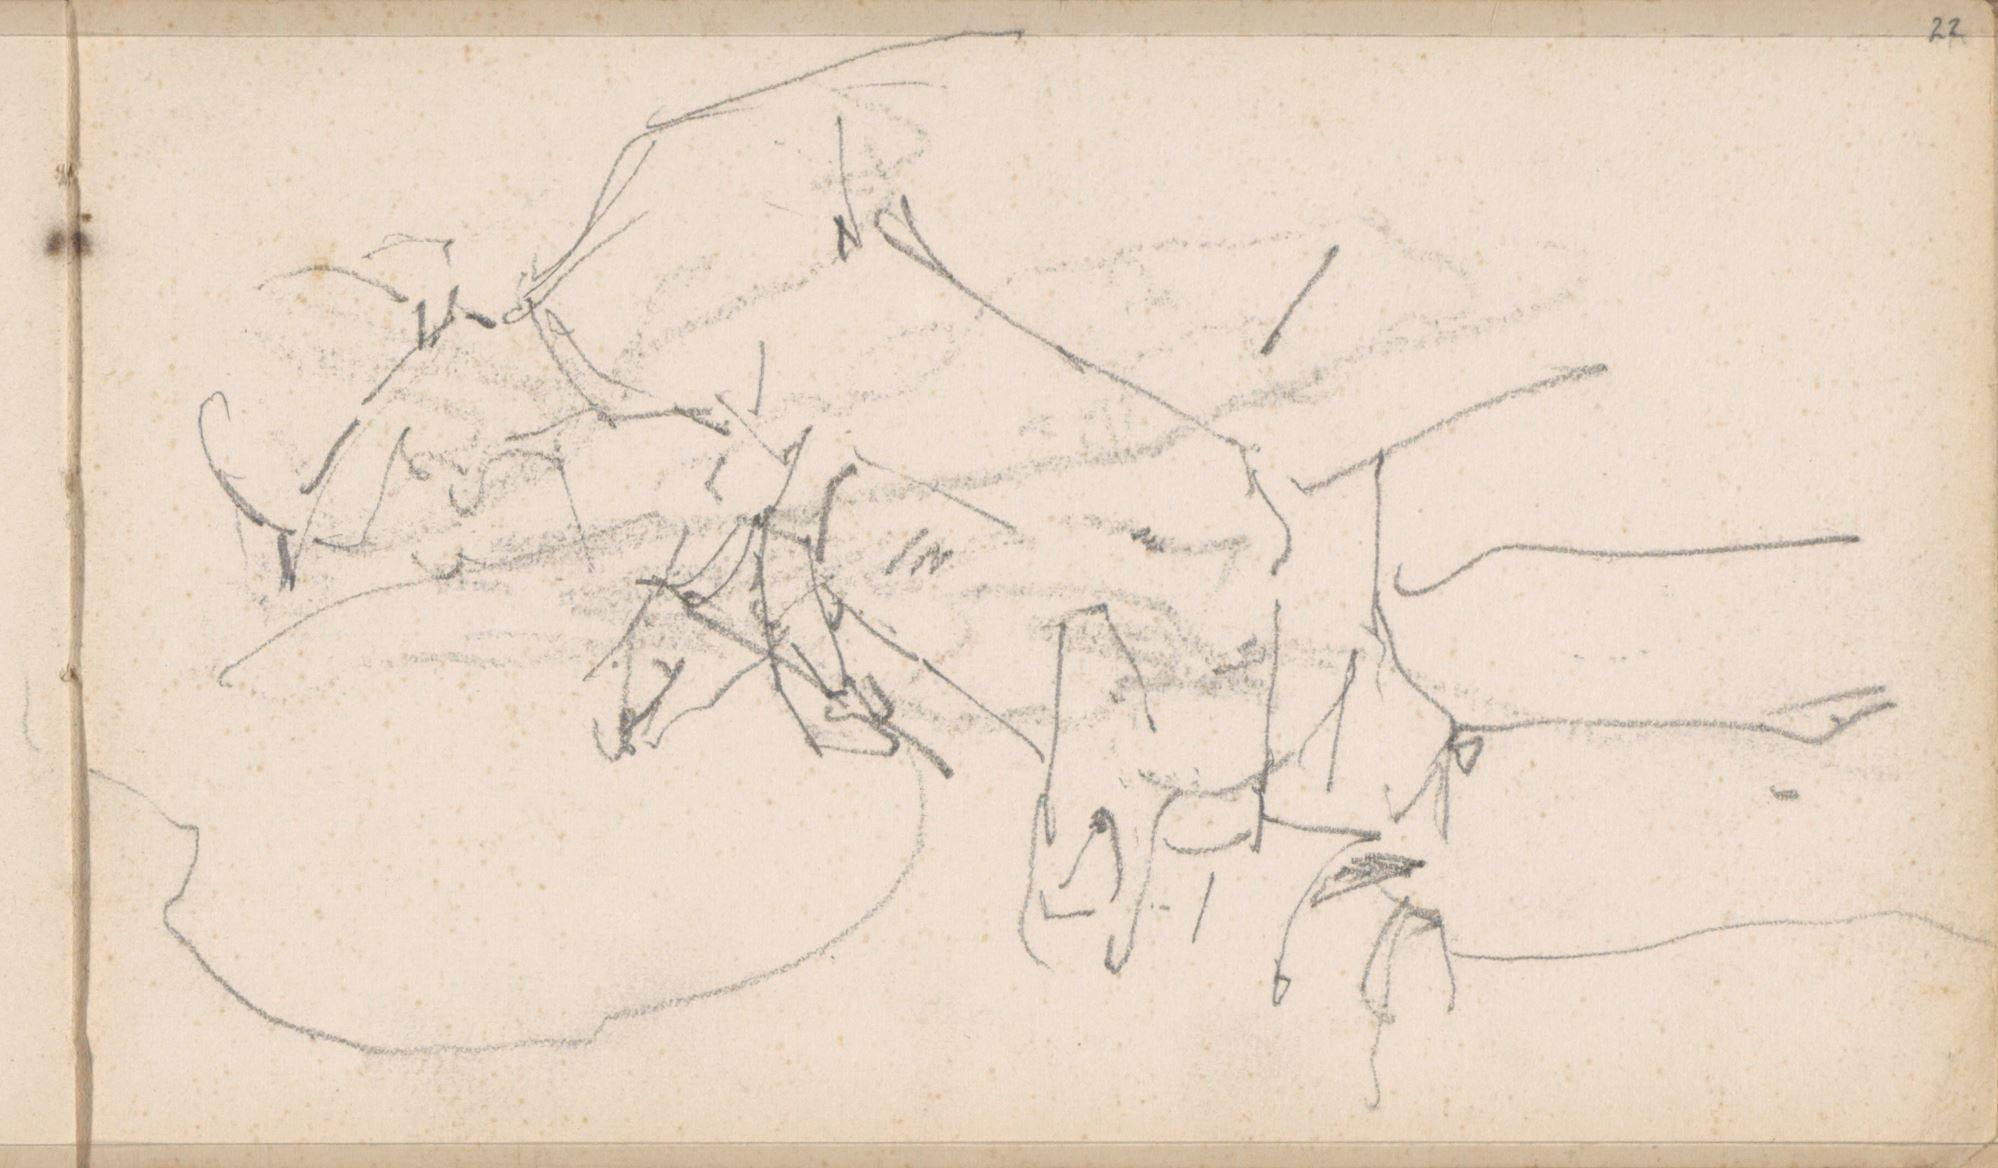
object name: sketchbook leaf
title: Zittende man met hoed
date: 1881-1883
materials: paper, pencil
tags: sitting figure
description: Pagina 22 uit een schetsboek met 30 bladen.